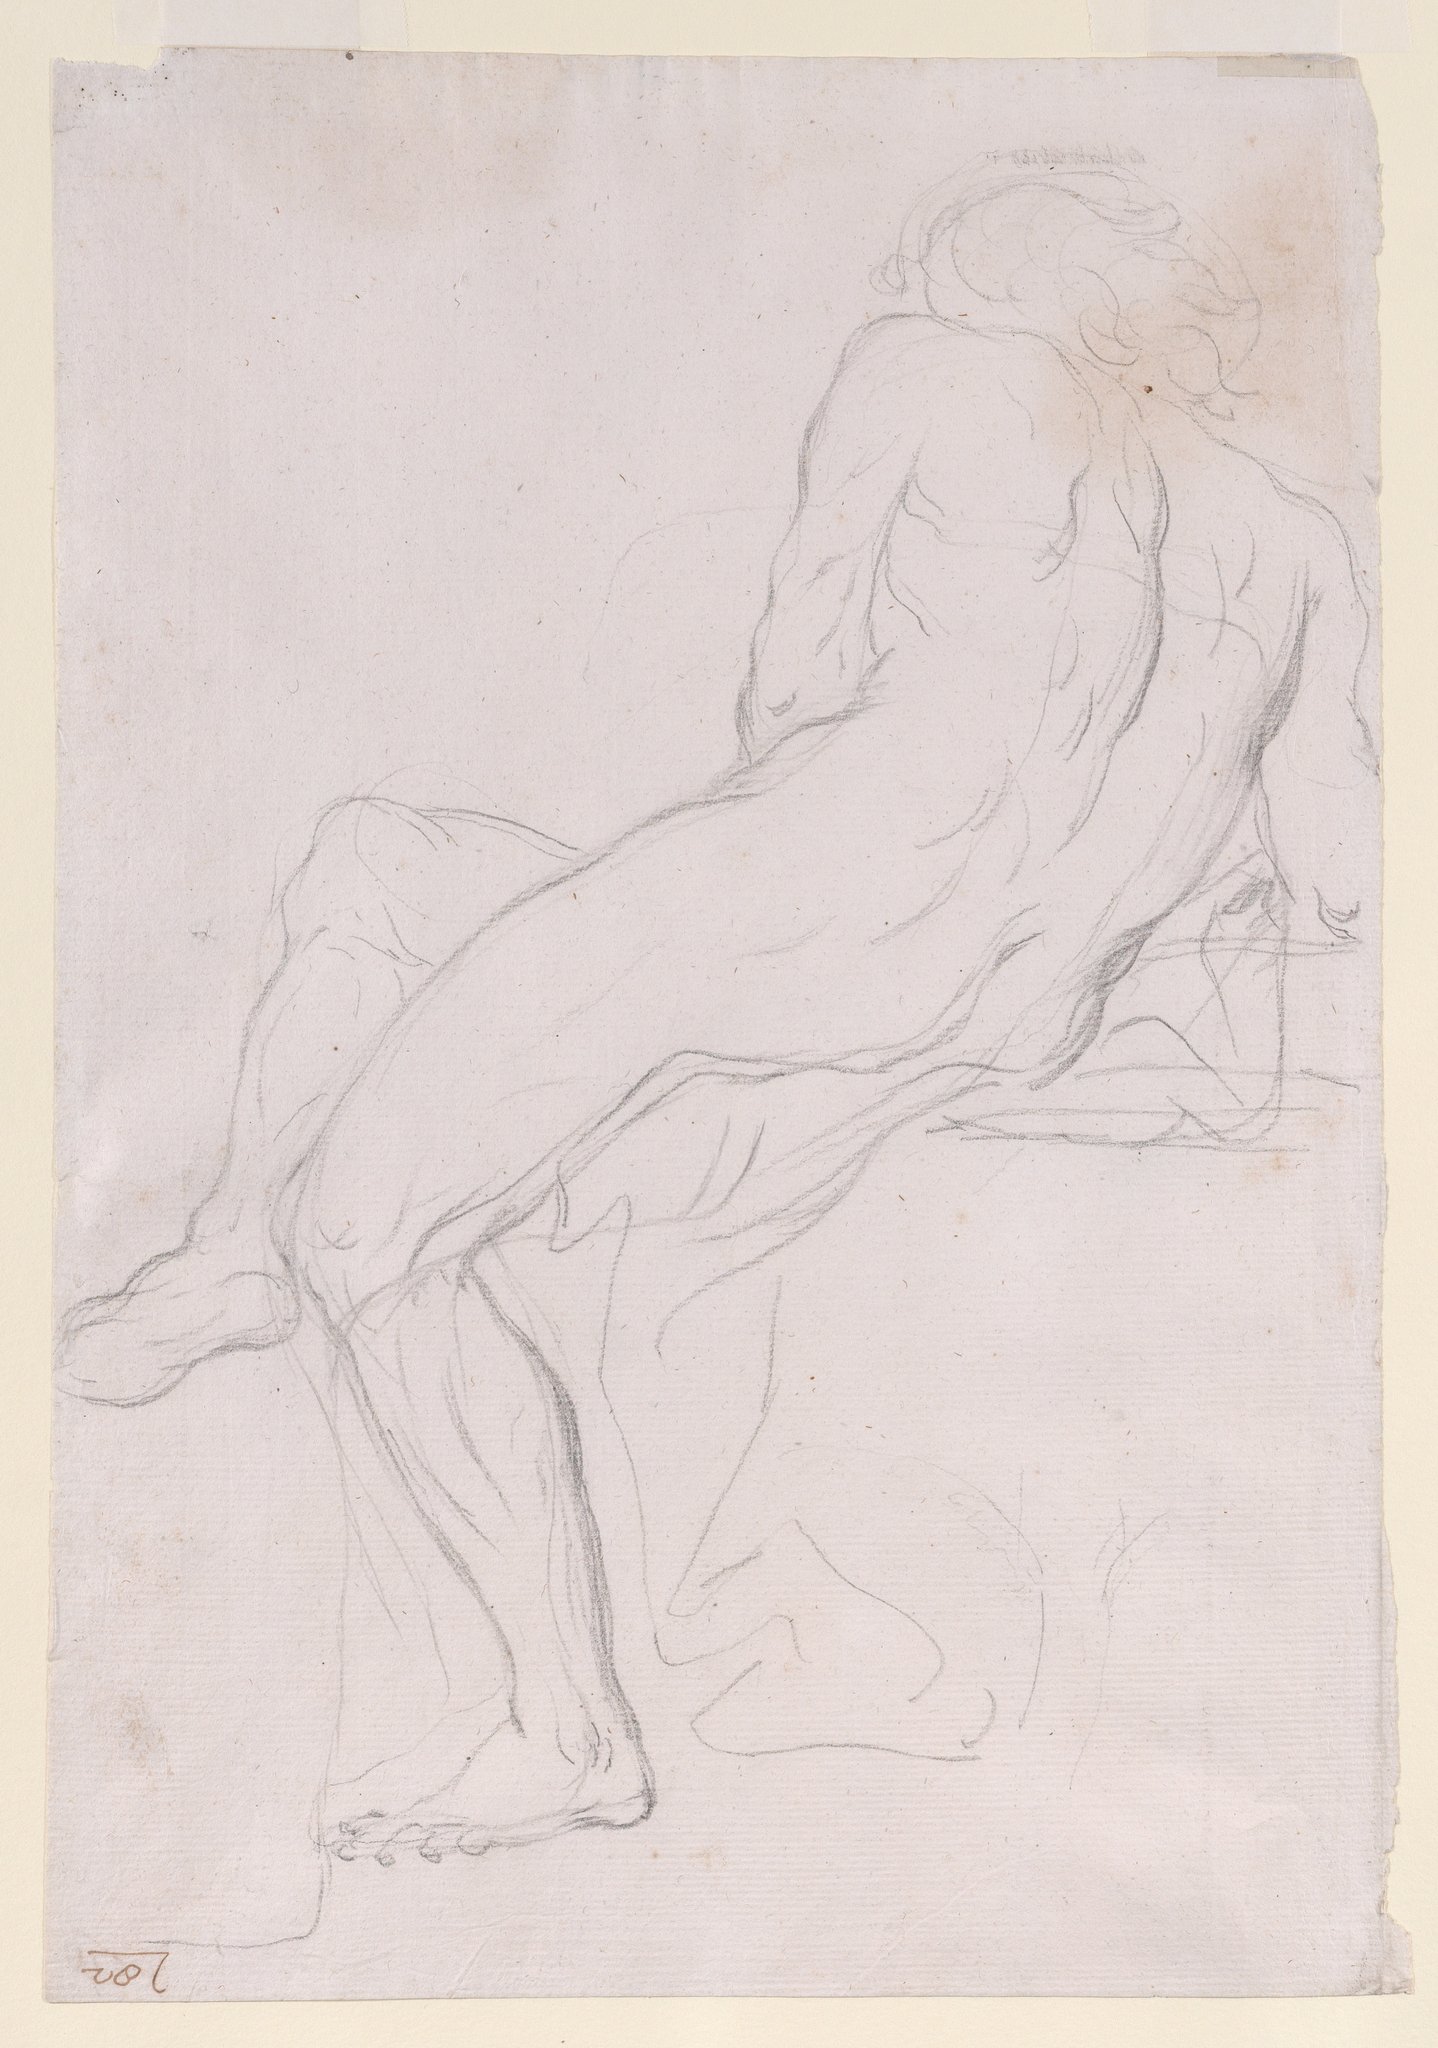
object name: drawing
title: Academy Sketch of a Seated Male Figure.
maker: giacomo zoboli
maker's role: artist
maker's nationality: italian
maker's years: 1681-1767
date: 1701-1800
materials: chalk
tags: male nudes